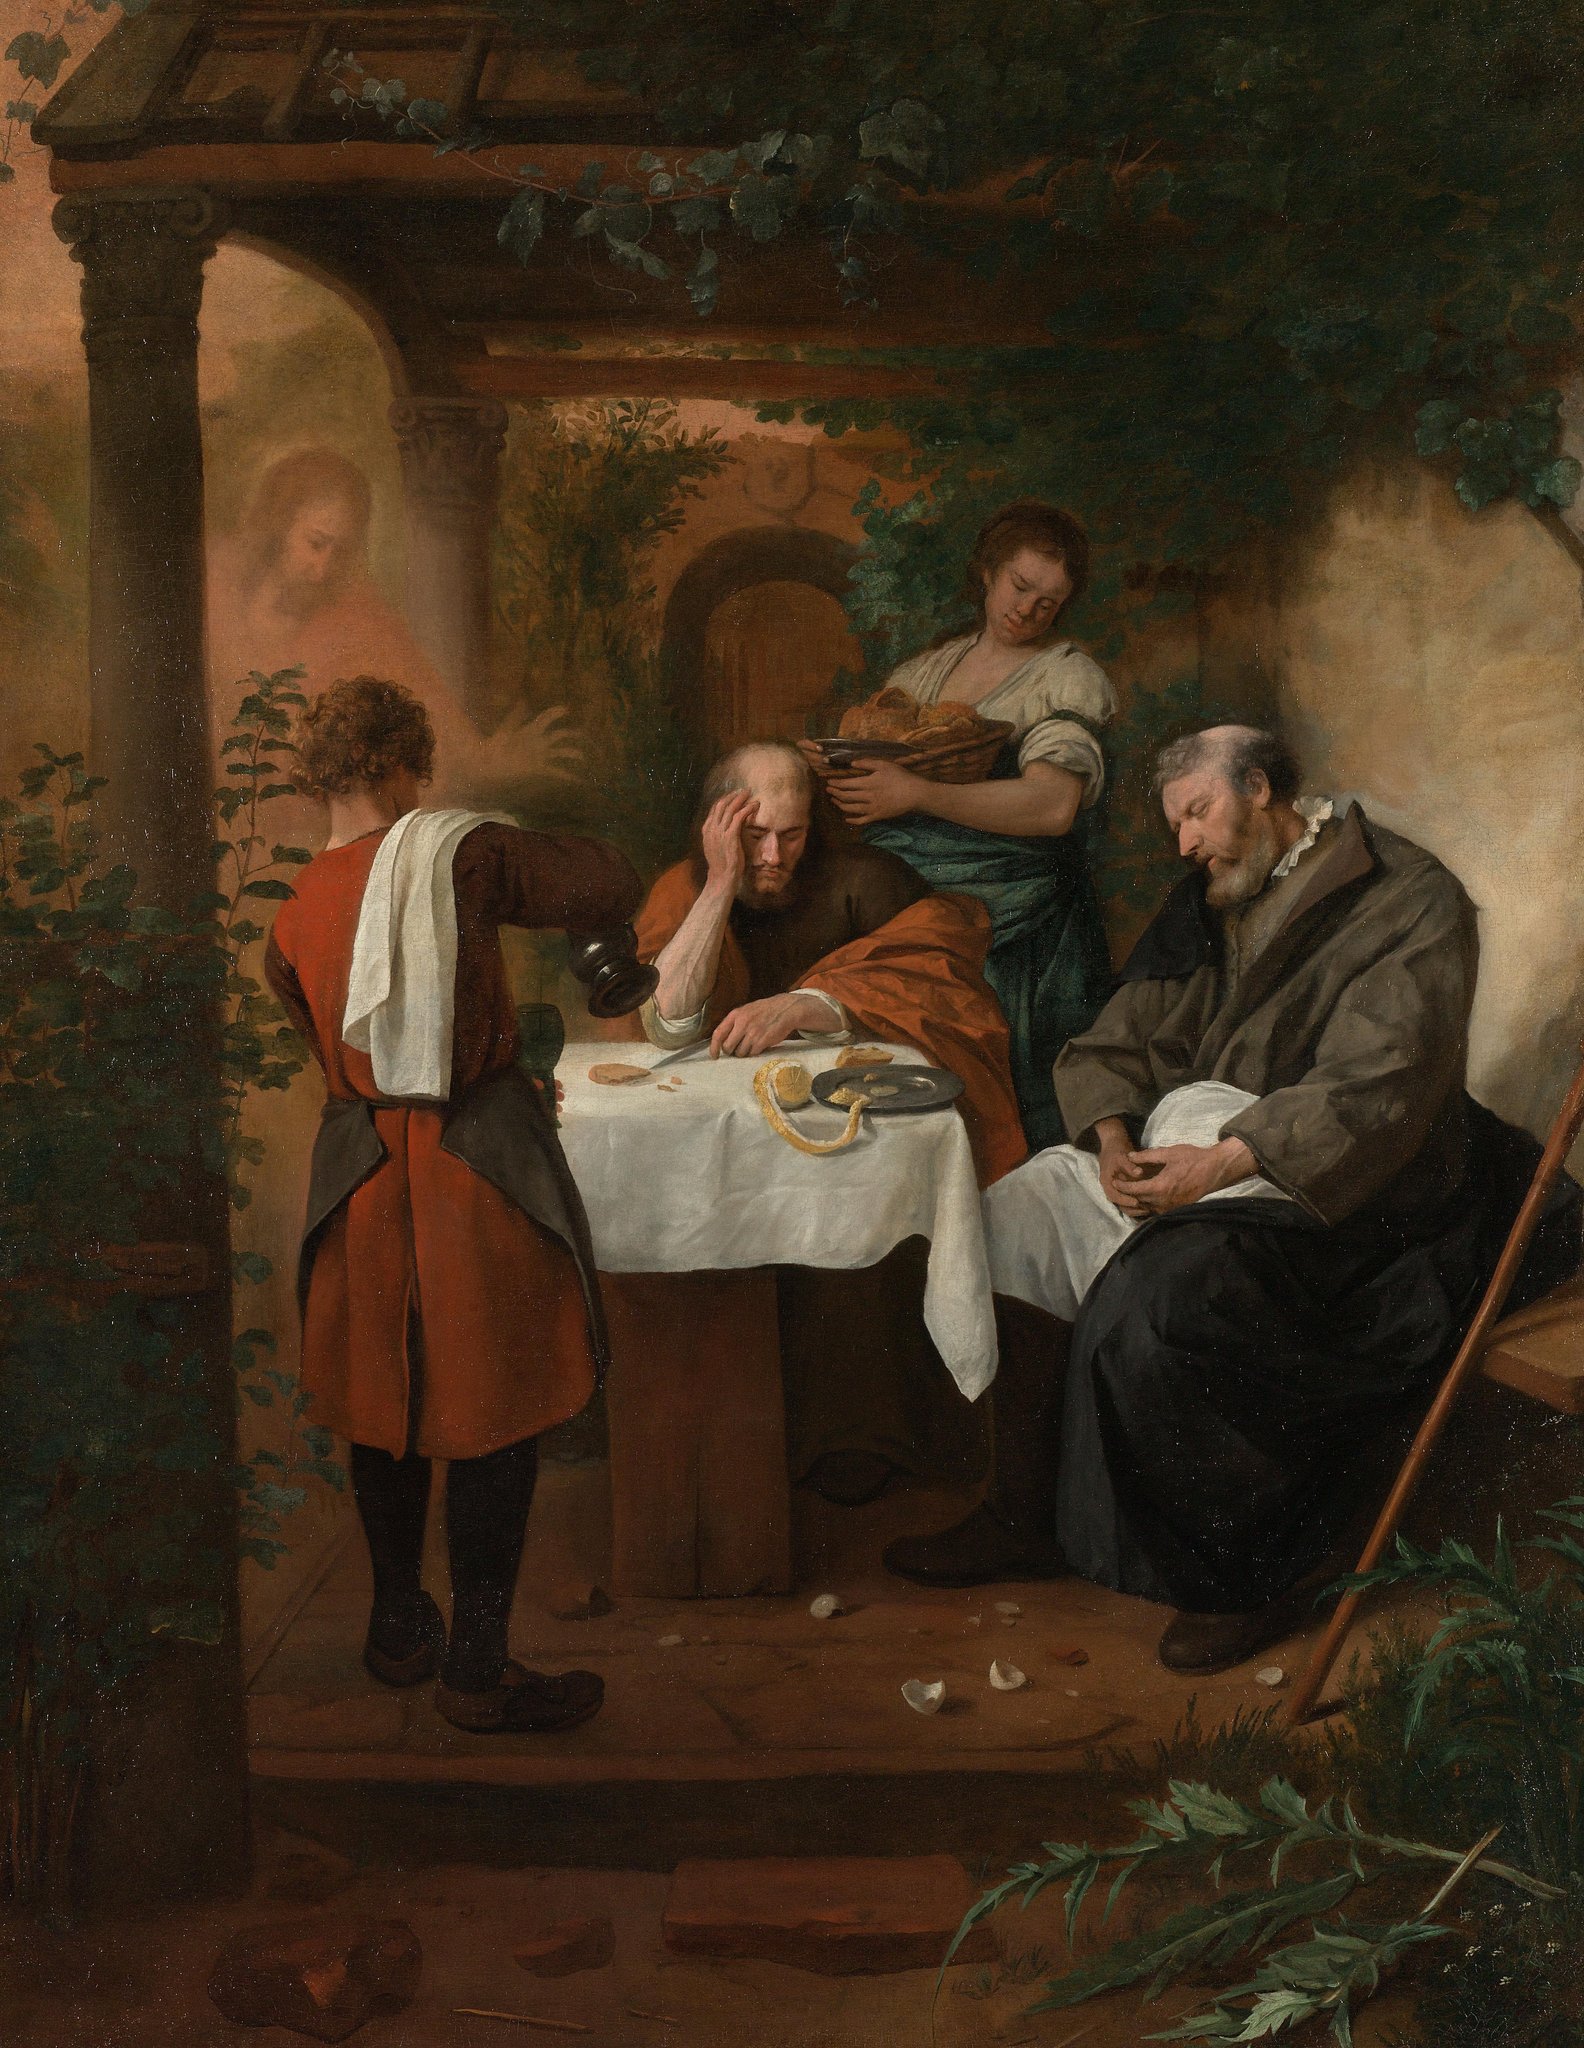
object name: painting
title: Supper at Emmaus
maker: jan havicksz. steen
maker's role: painter, print maker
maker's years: 1625-1679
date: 1665-1668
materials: canvas, oil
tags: the supper at emmaus: christ is recognized while blessing or breaking the bread, christ vanishes ~ supper at emmaus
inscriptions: signature: ‘JSteen’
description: On their way to Emmaus, two Disciples unexpectedly encounter Christ. At first they do not recognise him. As they sit to eat and they break bread, they realise who he is. And at that moment, he disappears. That is the moment Jan Steen depicts here: Christ’s shade is just visible on the left beneath the arbour.